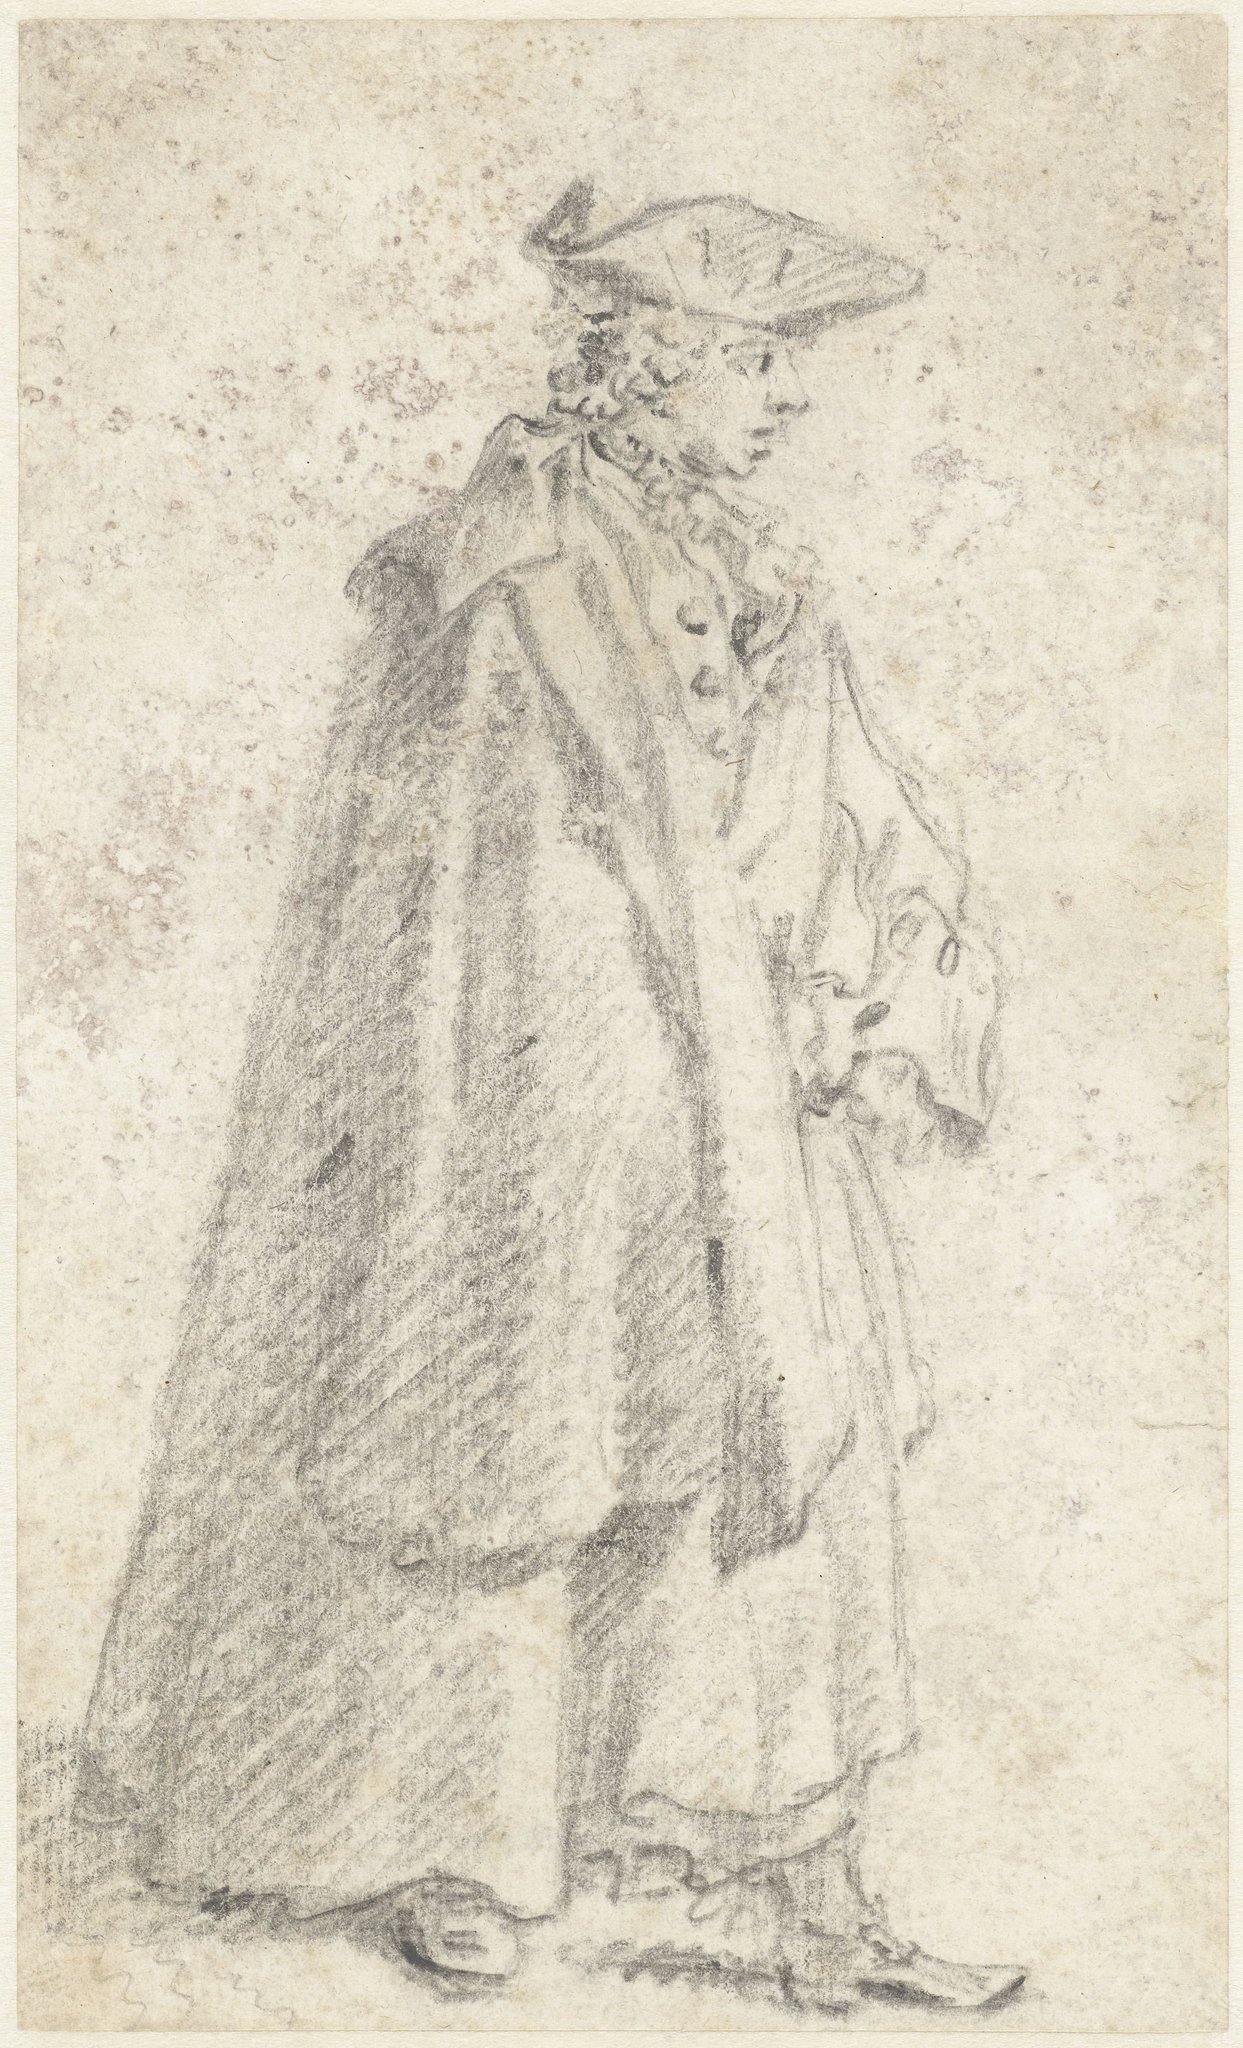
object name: drawing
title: Figuurstudie van een staande man, bijna en profil naar rechts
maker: simon fokke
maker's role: draughtsman, print maker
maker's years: 1712-1784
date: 1722-1784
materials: chalk, paper